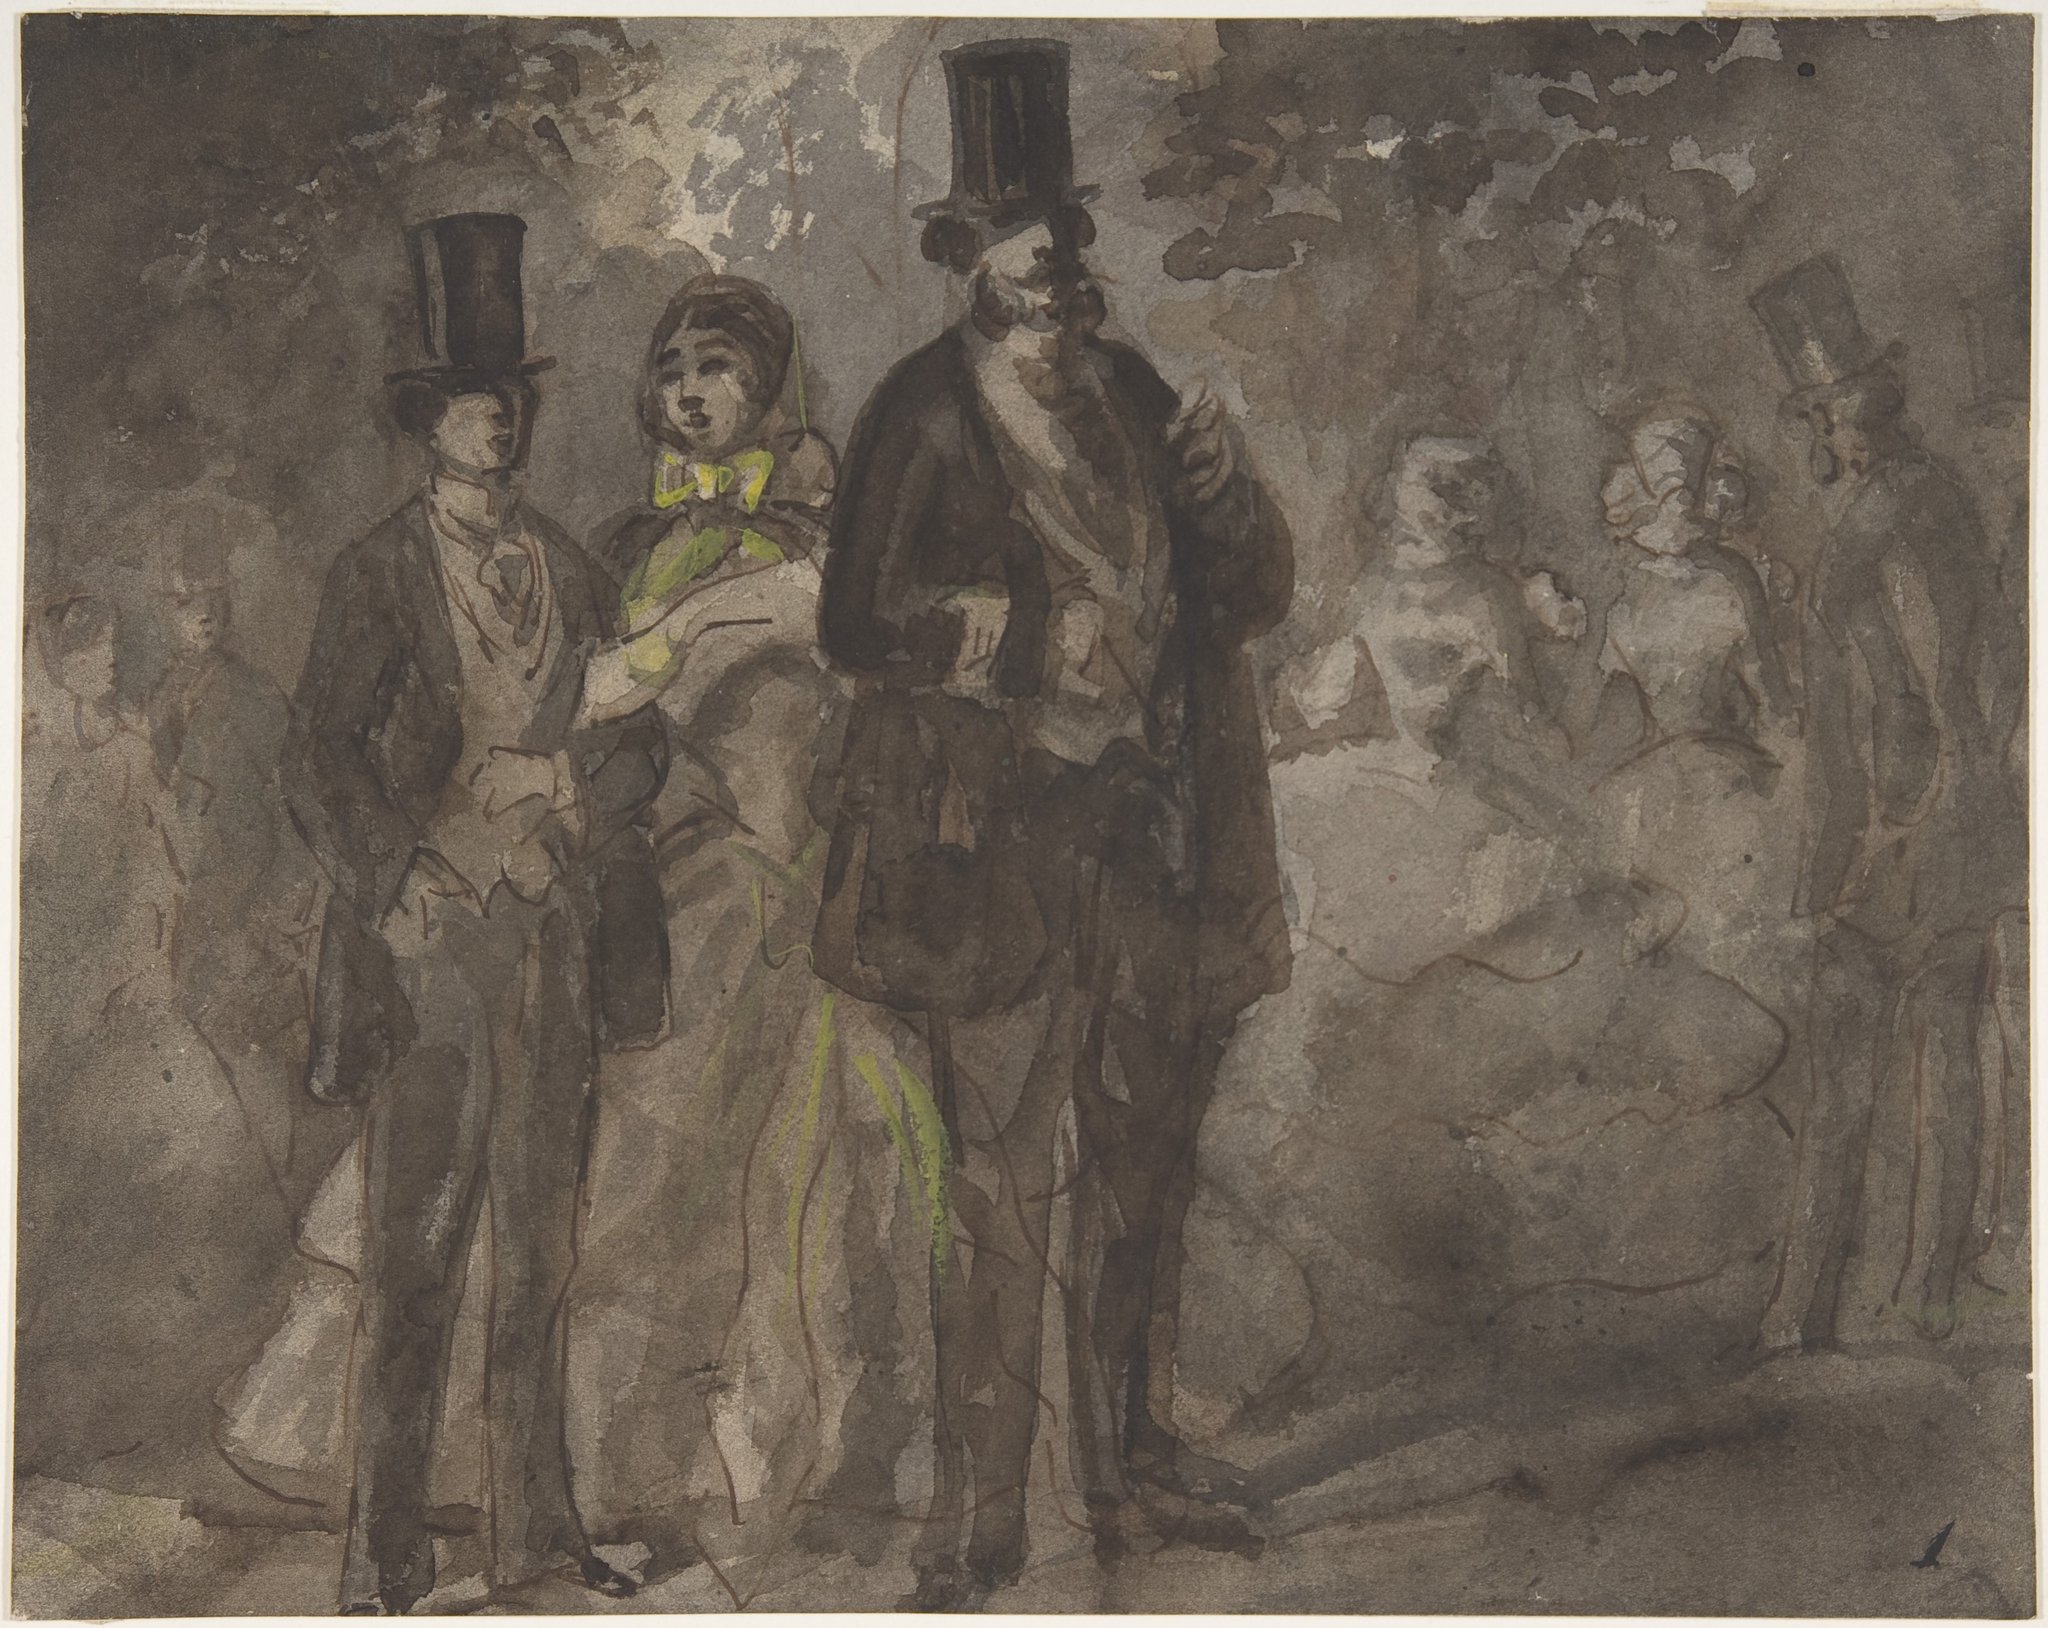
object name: drawing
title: Walking in the Park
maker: constantin guys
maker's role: artist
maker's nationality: french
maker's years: 1802-1892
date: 1801-1900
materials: ink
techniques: brush, pen, wash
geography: france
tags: men,women